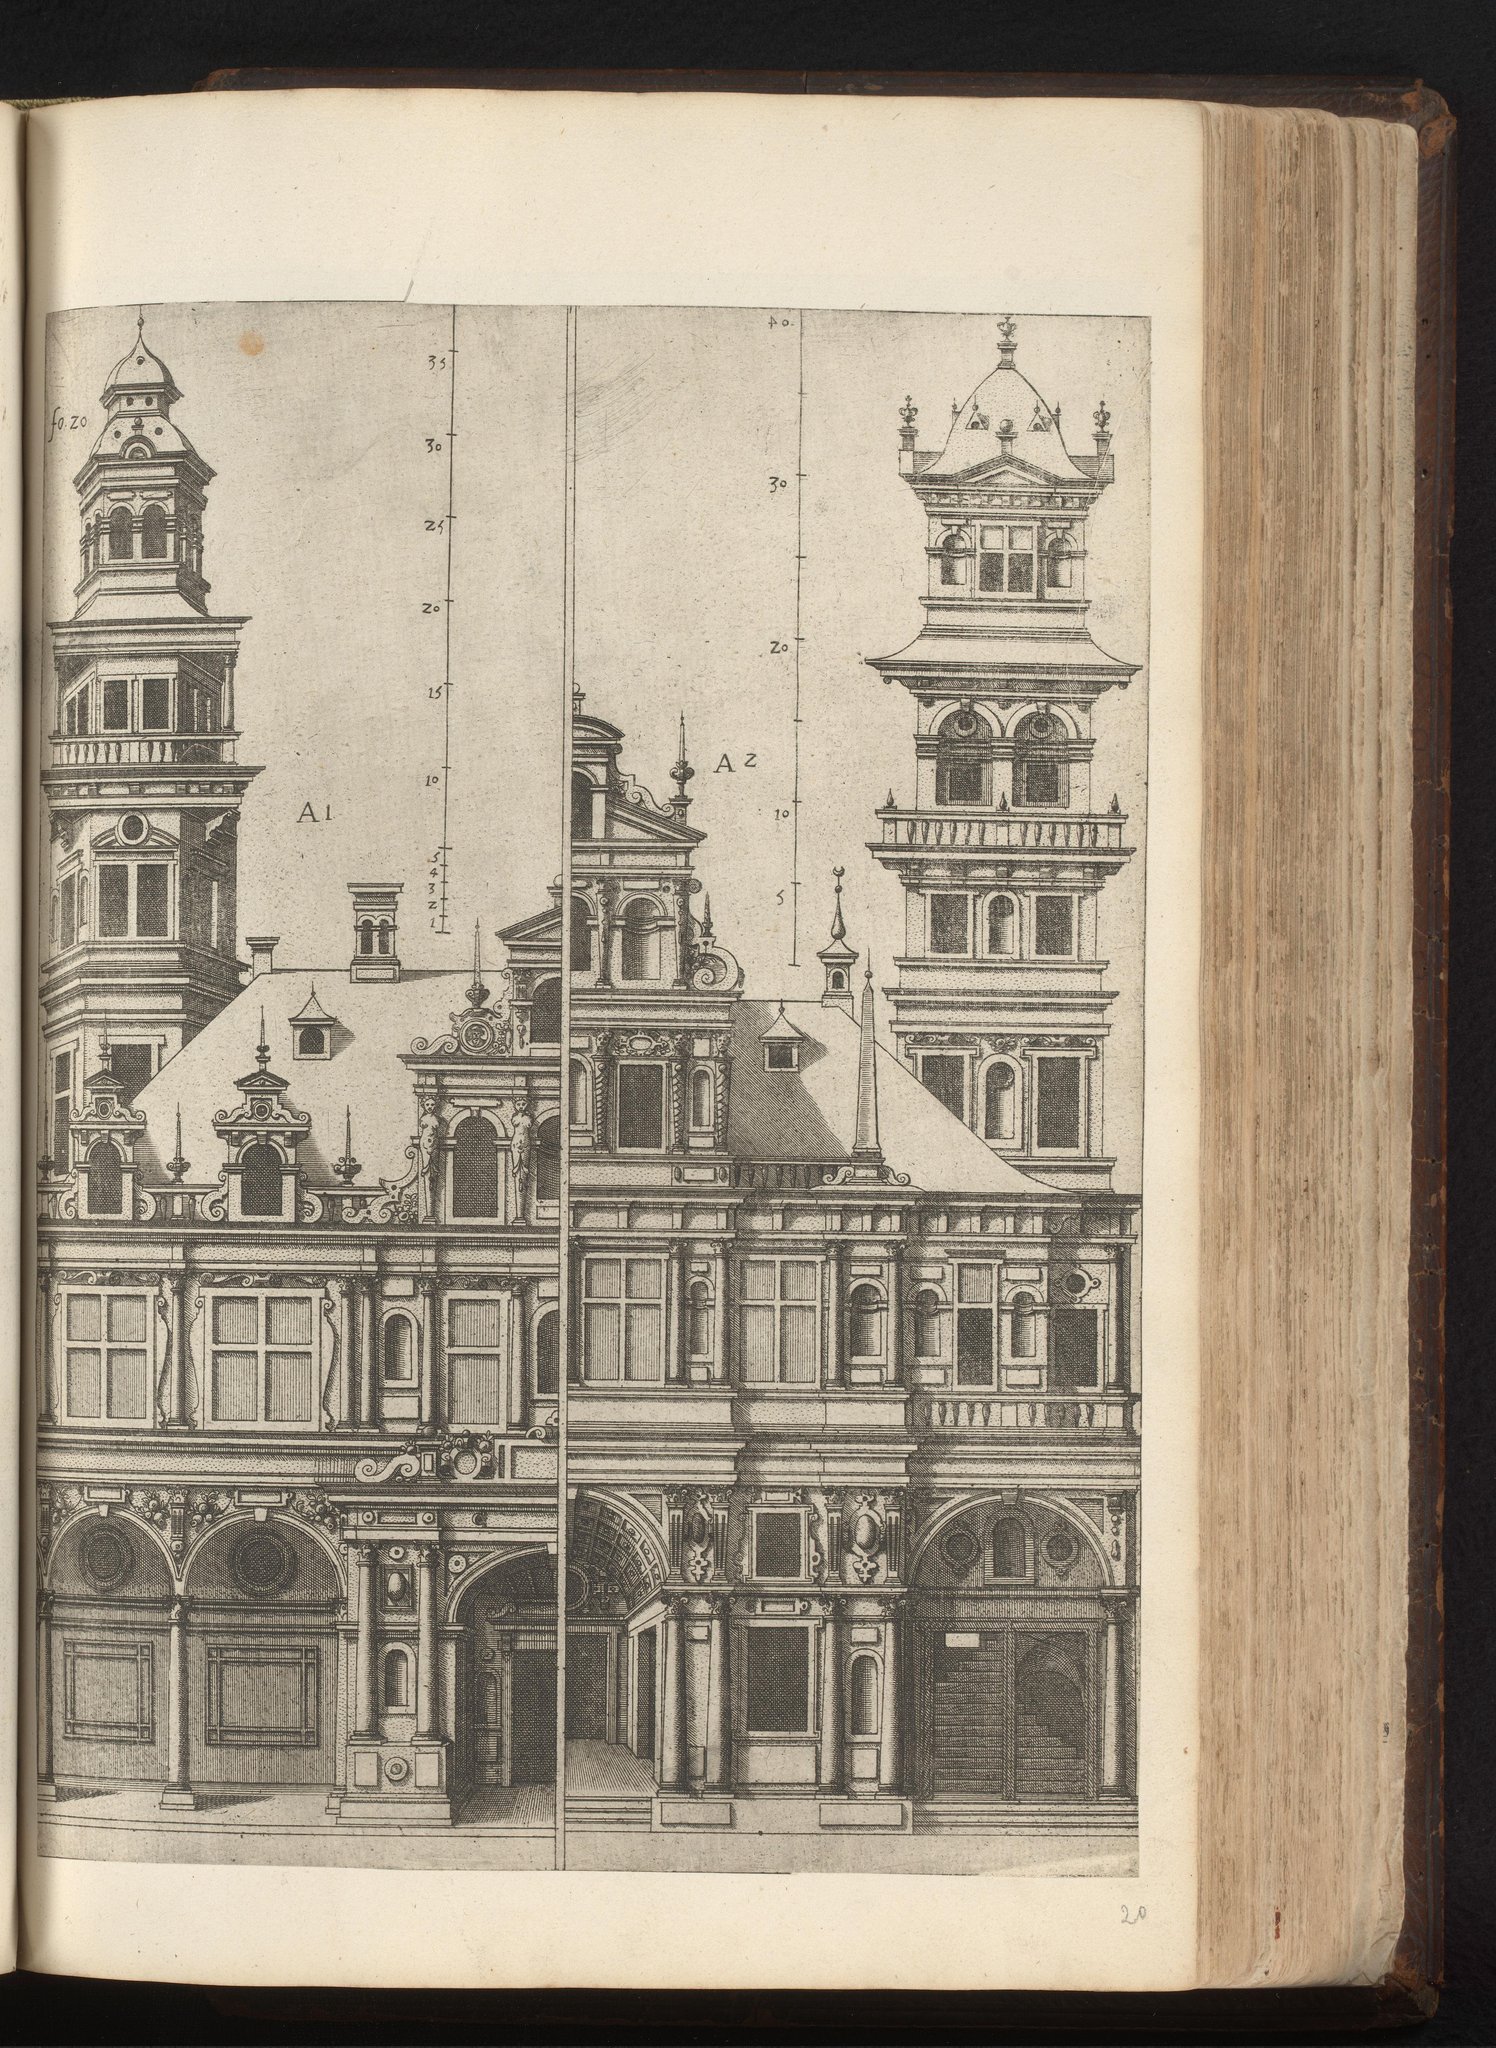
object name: album leaf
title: Gevels in de Korinthische orde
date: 1581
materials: paper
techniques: engraving, etching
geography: antwerp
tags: civic architecture; edifices; dwellings, corinthian order ~ architecture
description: Prent uit: Vredeman de Vries, Hans. Architectura oder Bauung der Antiquen auss dem Vitruvius, waellches sein funff Collummen orden, (...). Antwerpen: Gerard de Jode en Gerard Smits, 1581. Prent eerder verschenen in de 1577-editie.